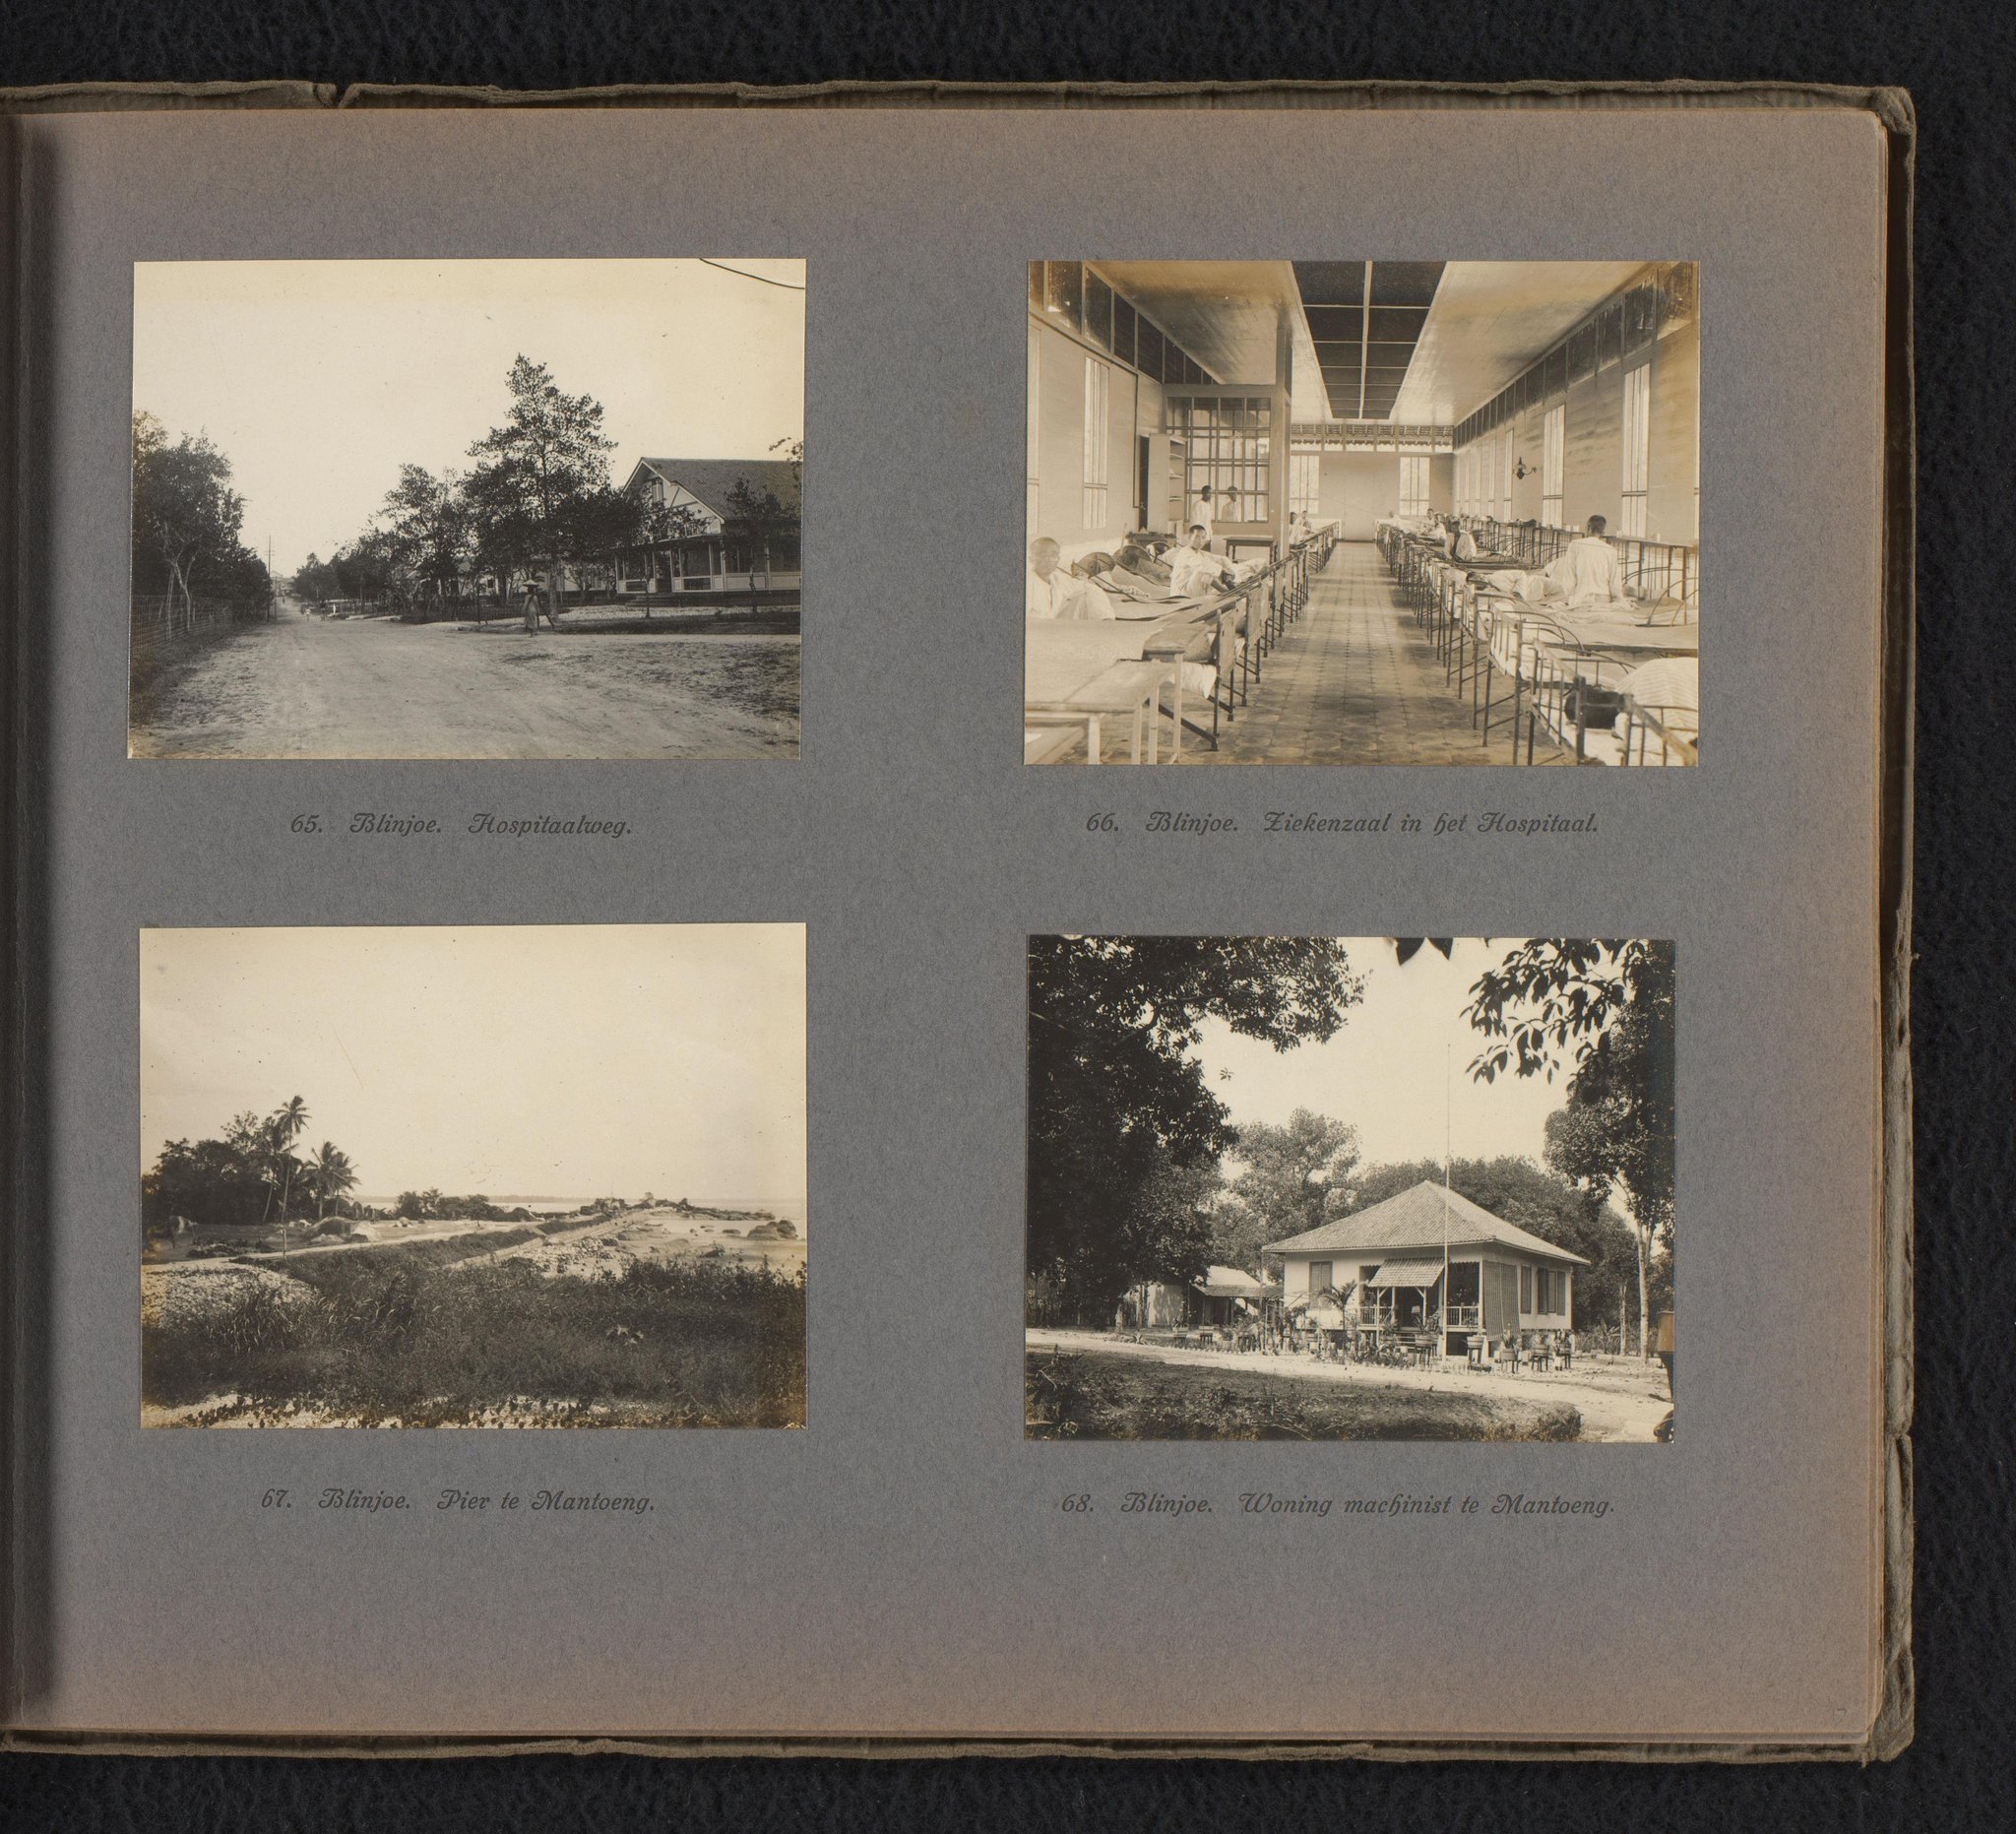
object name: album leaf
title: Gebouwen te Blinjoe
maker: Anonymous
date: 1907-1919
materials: cardboard, photographic support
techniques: gelatin silver print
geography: bangka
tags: robert julius boers, colonial system, rural housing, e.g. country-house, villa, cottage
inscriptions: inscription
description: Albumblad met vier foto's genummerd 65-68 van verschillende gebouwen te Belinyu (Blinjoe) op Banka: ziekenhuis, pier en woning. Onderdeel van het Banka-Album met foto's over het eiland Banka en de tinwinning door het staatsbedrijf de Banka-tinwinning in de periode ca. 1907-1919.